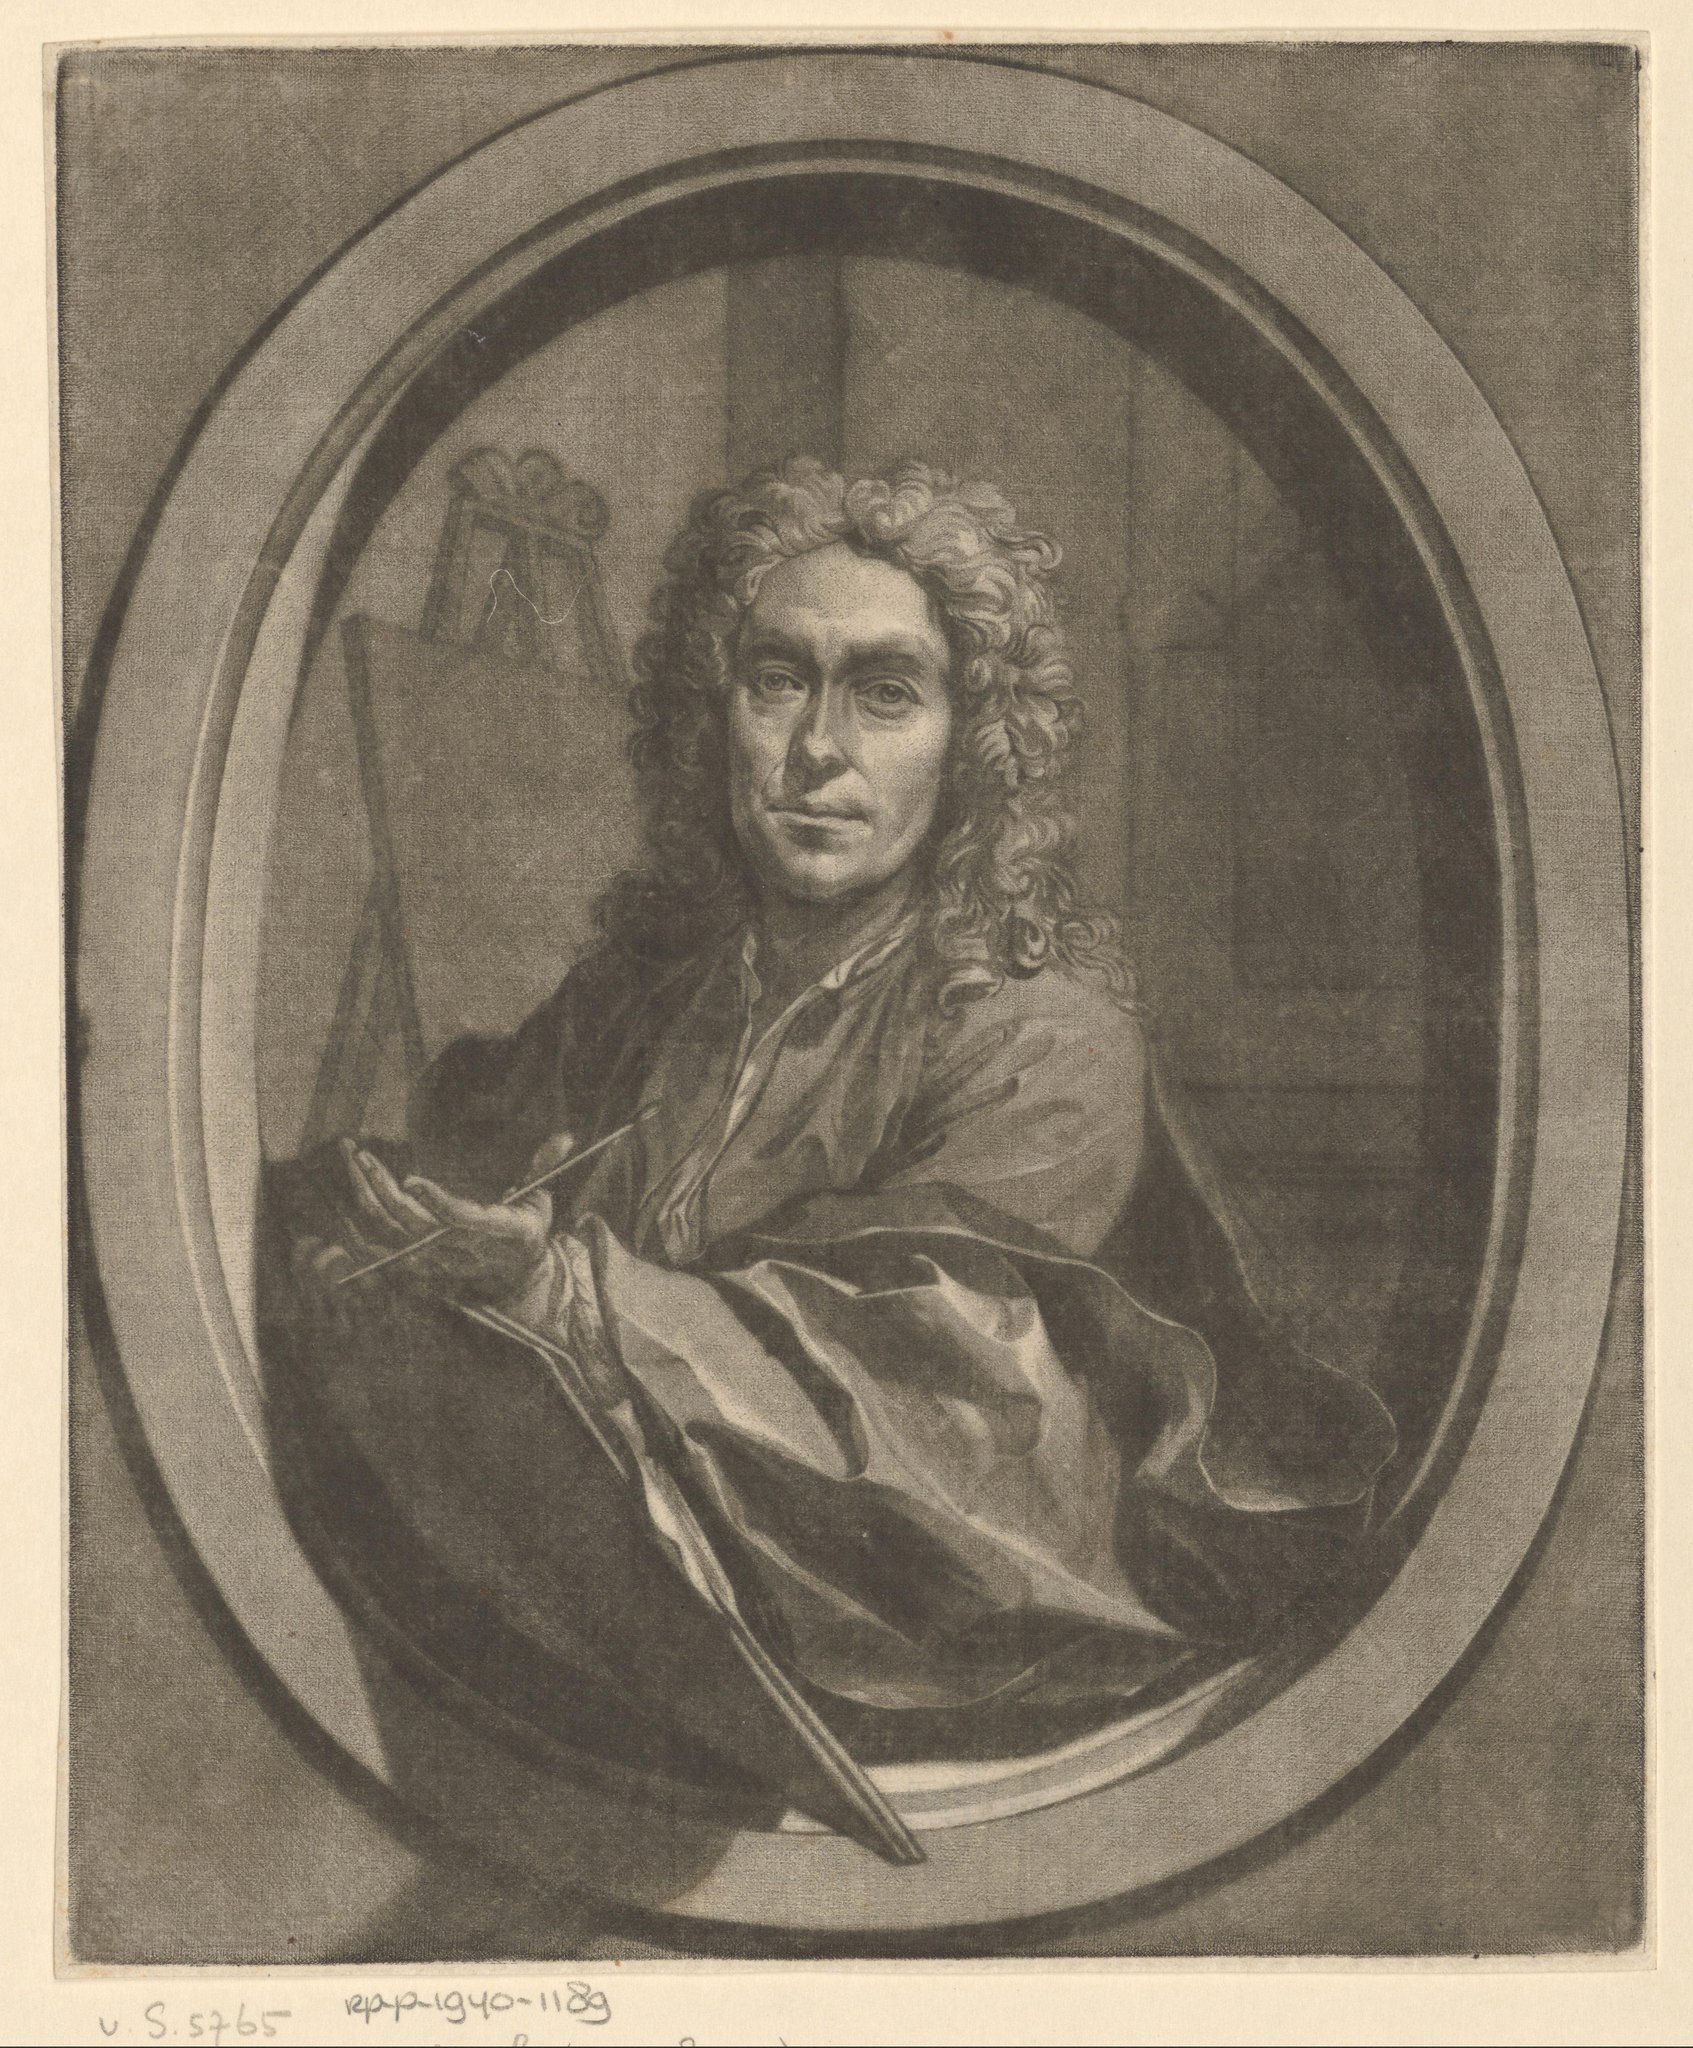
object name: print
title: Portret van Nicolaas Verkolje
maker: arnout rentinck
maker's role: draughtsman, print maker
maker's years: 1712-1774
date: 1722-1774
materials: paper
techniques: mezzotint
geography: low countries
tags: delft, painter, nicolaas verkolje, historical persons, portrait, self-portrait of painter, tools, implements of painter, portrait, self-portrait of graphic artist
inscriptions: collector's mark: Lugt 2760, inscription: ‘N. Verkolje (?) Pinx. / Arentinc F.’, inscription: ‘Het pourtret van de kunstschilder / Nicolaas Verkolje / Geofreerd aan mijnen / Zeer Waarde Vriend / de W.Ed heer, Cornelius (?) / P.v.A.’, collector's mark: Lugt 2228